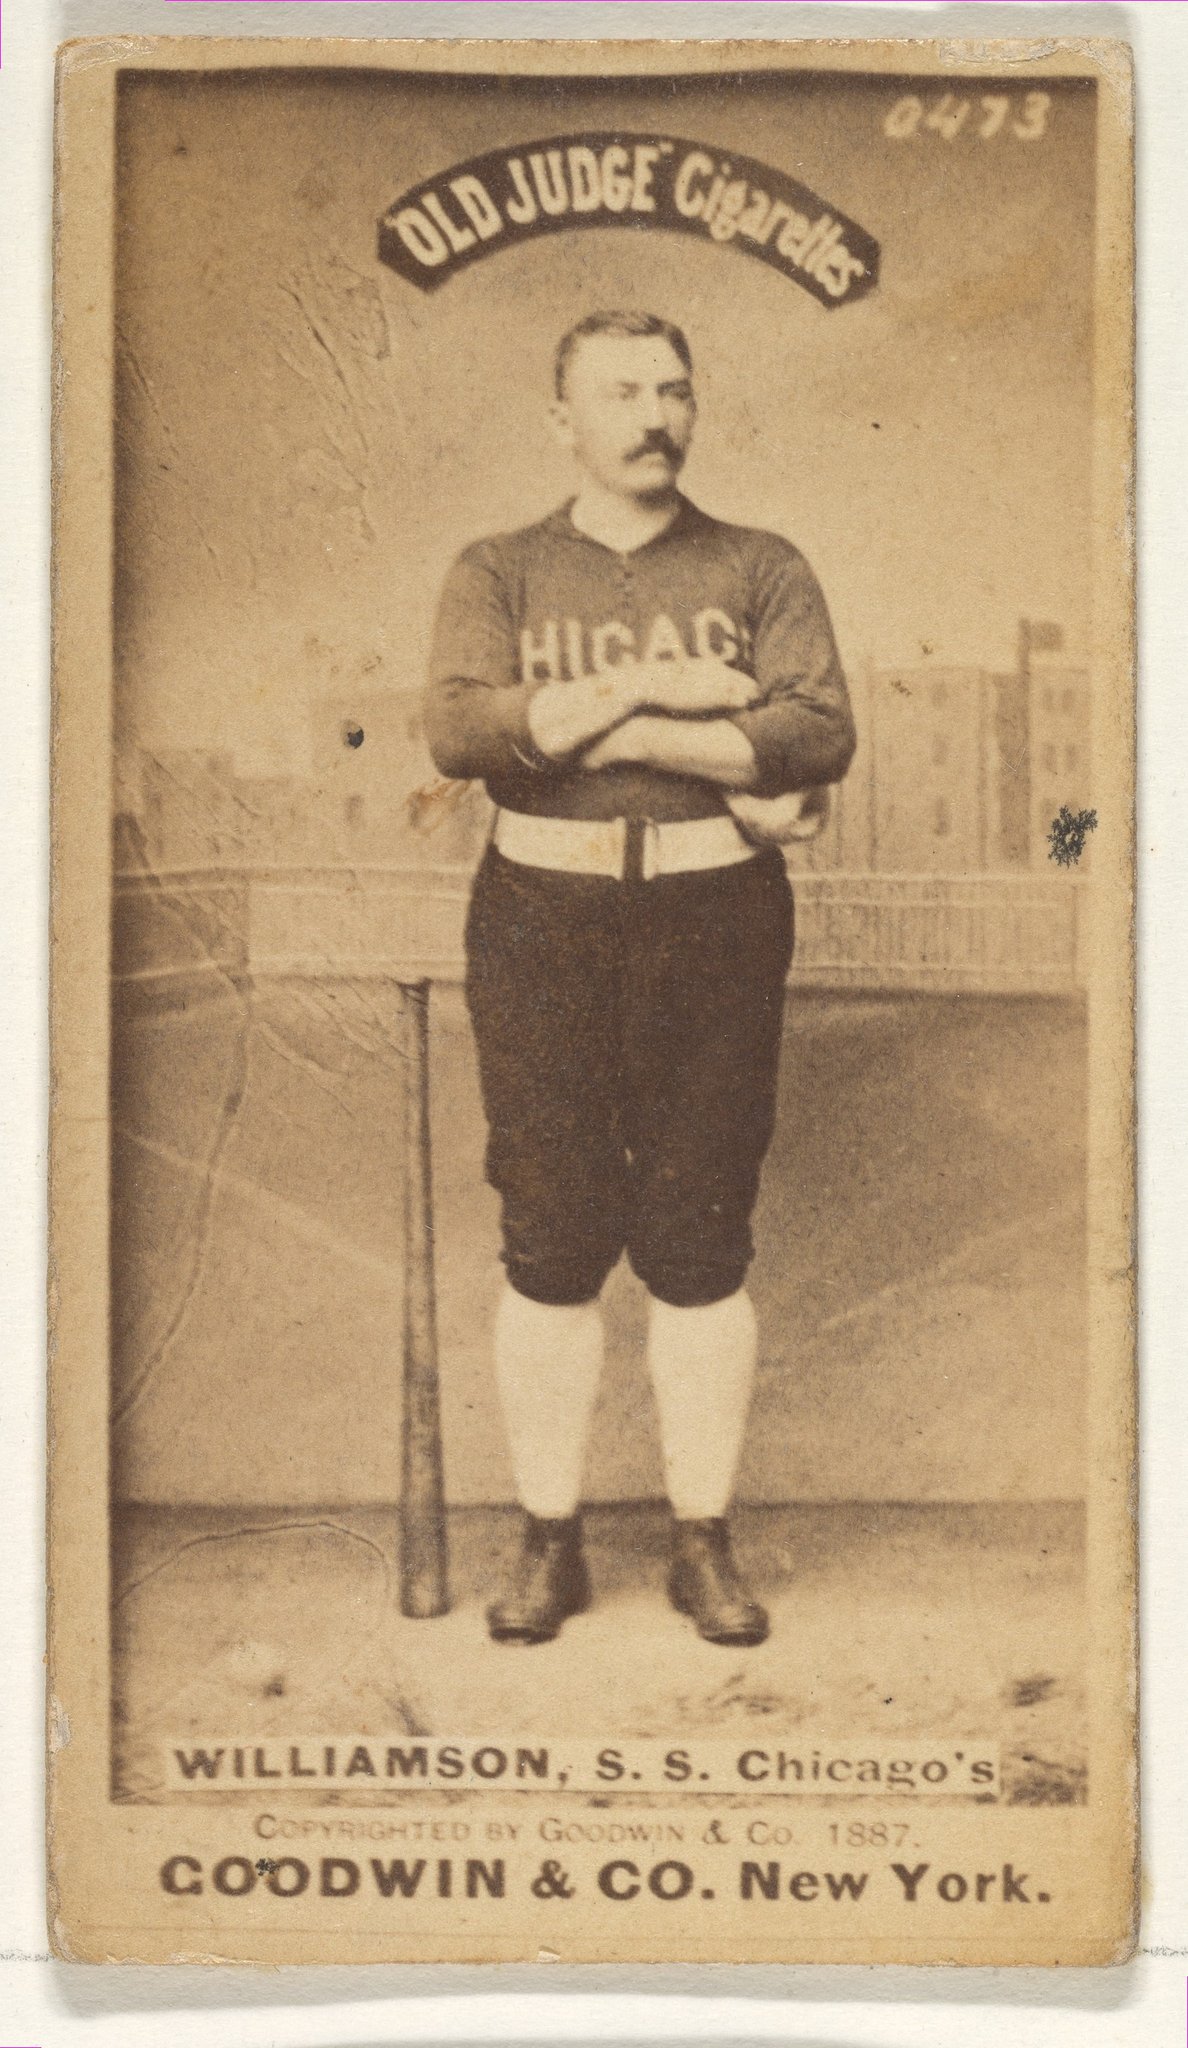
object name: baseball card, photograph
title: Williamson, Shortstop, Chicago, from the Old Judge series (N172) for Old Judge Cigarettes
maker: goodwin & company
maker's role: publisher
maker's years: 1850-1950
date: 1887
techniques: albumen silver print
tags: men,portraits,baseball,athletes